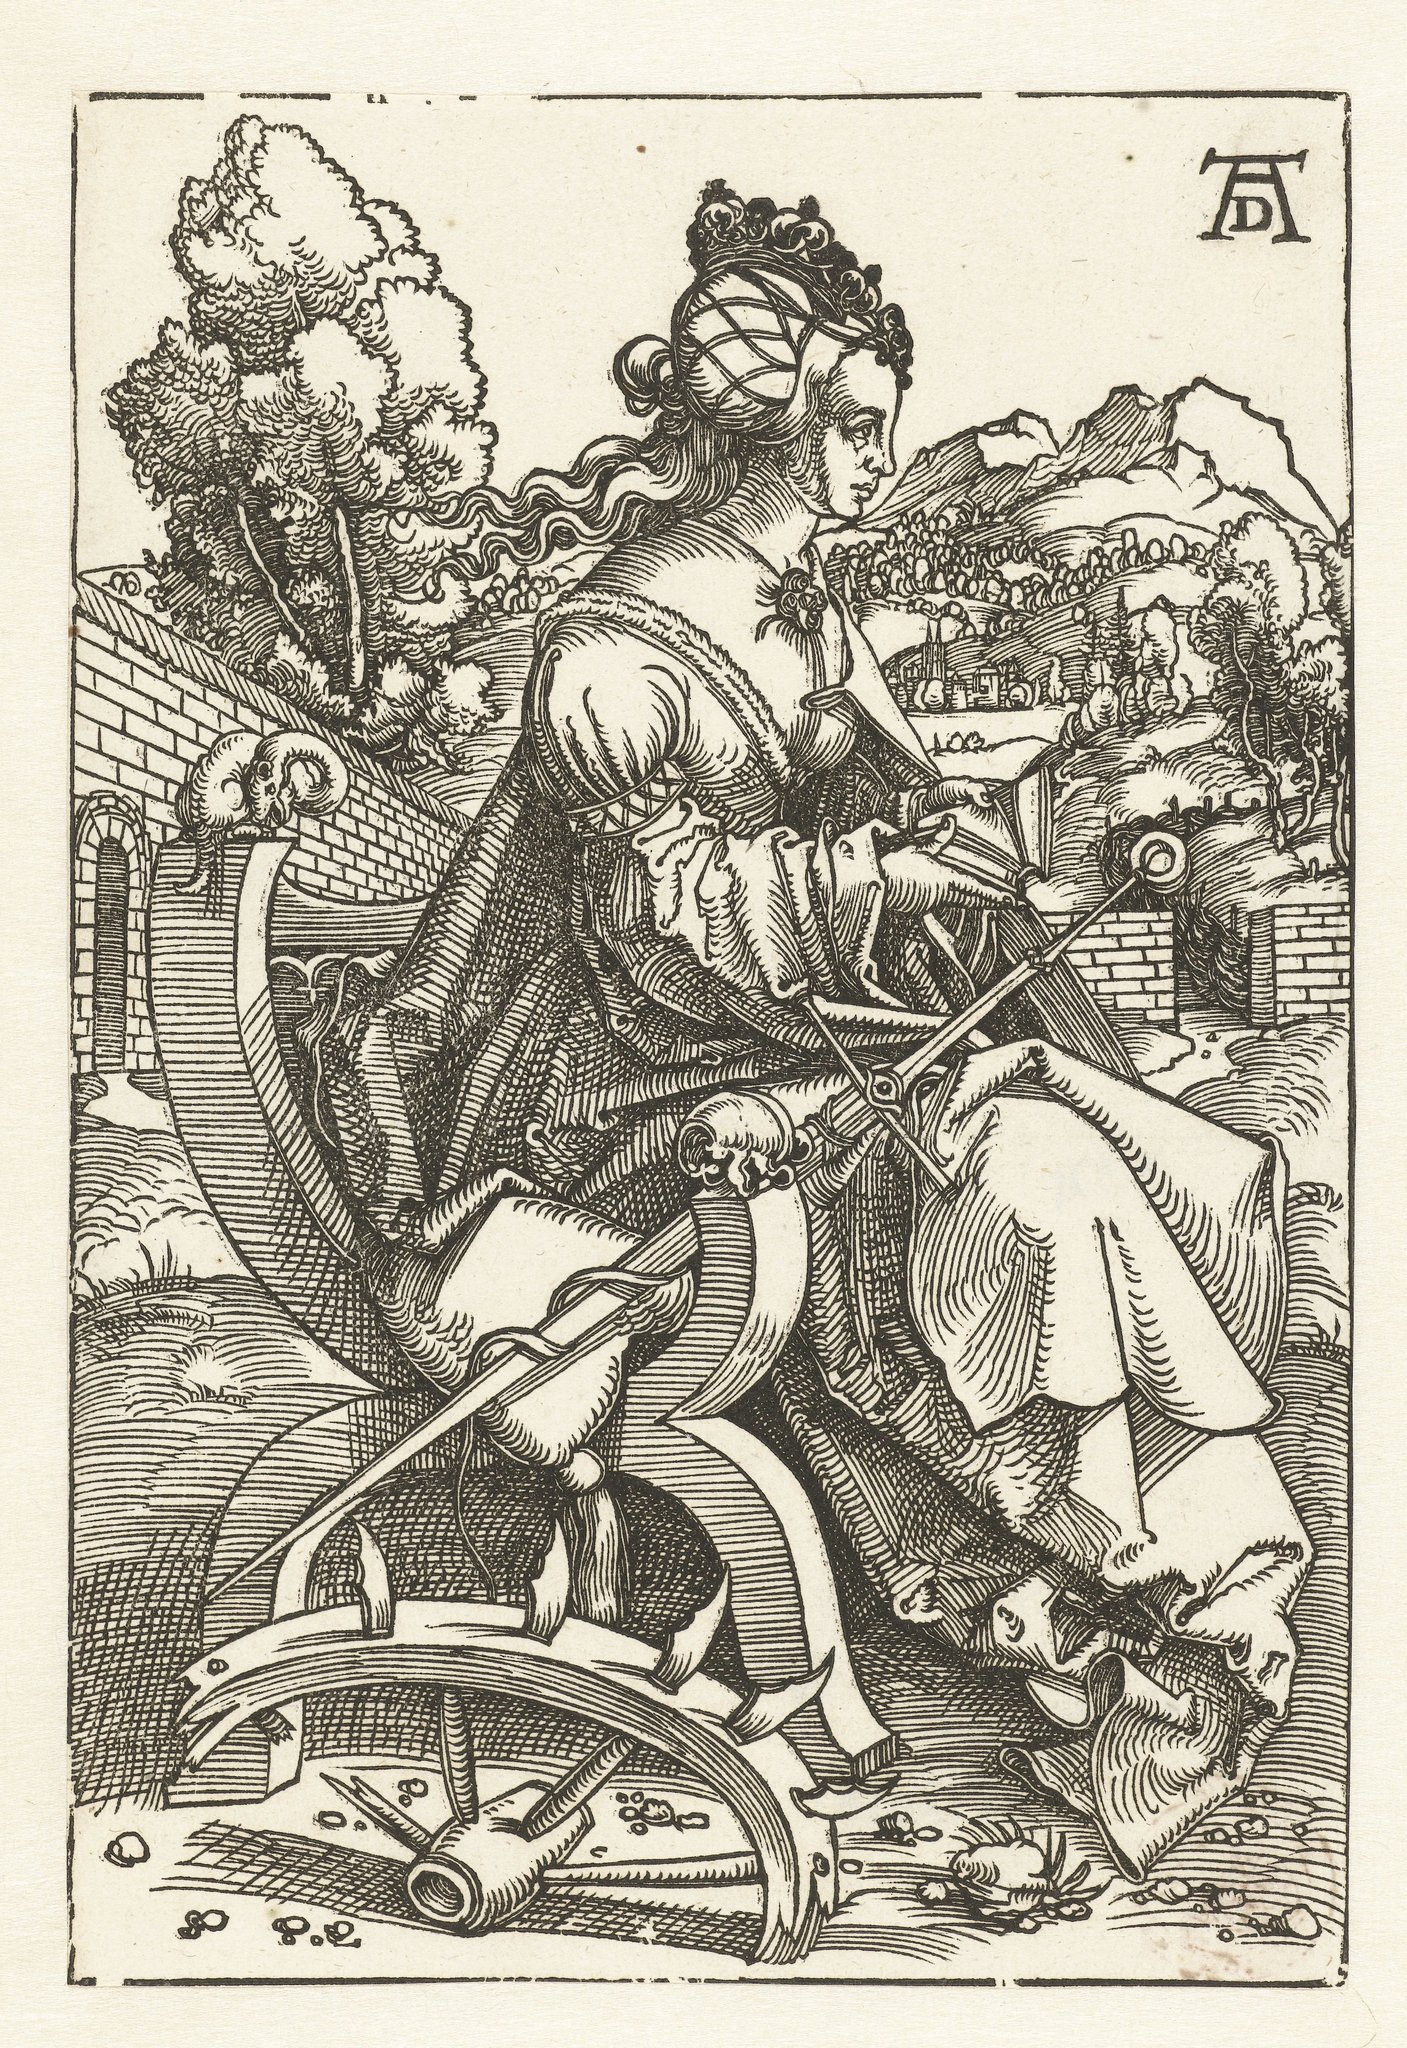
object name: print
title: Catharina van Alexandrië met gebroken wiel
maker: hans baldung grien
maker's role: draughtsman, print maker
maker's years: 1484-1545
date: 1505-1507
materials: paper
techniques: woodcut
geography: nuremberg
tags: the virgin martyr catherine of alexandria; possible attributes: book, crown, emperor maxentius, palm-branch, ring, sword, wheel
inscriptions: collector's mark: Lugt 240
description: Heilige Catharina van Alexandrië zit op een stoel naar rechts gewend in een landschap. Zij houdt een boek vast en naast haar ligt een zwaard. Op de grond ligt haar attribuut, een gebroken wiel.